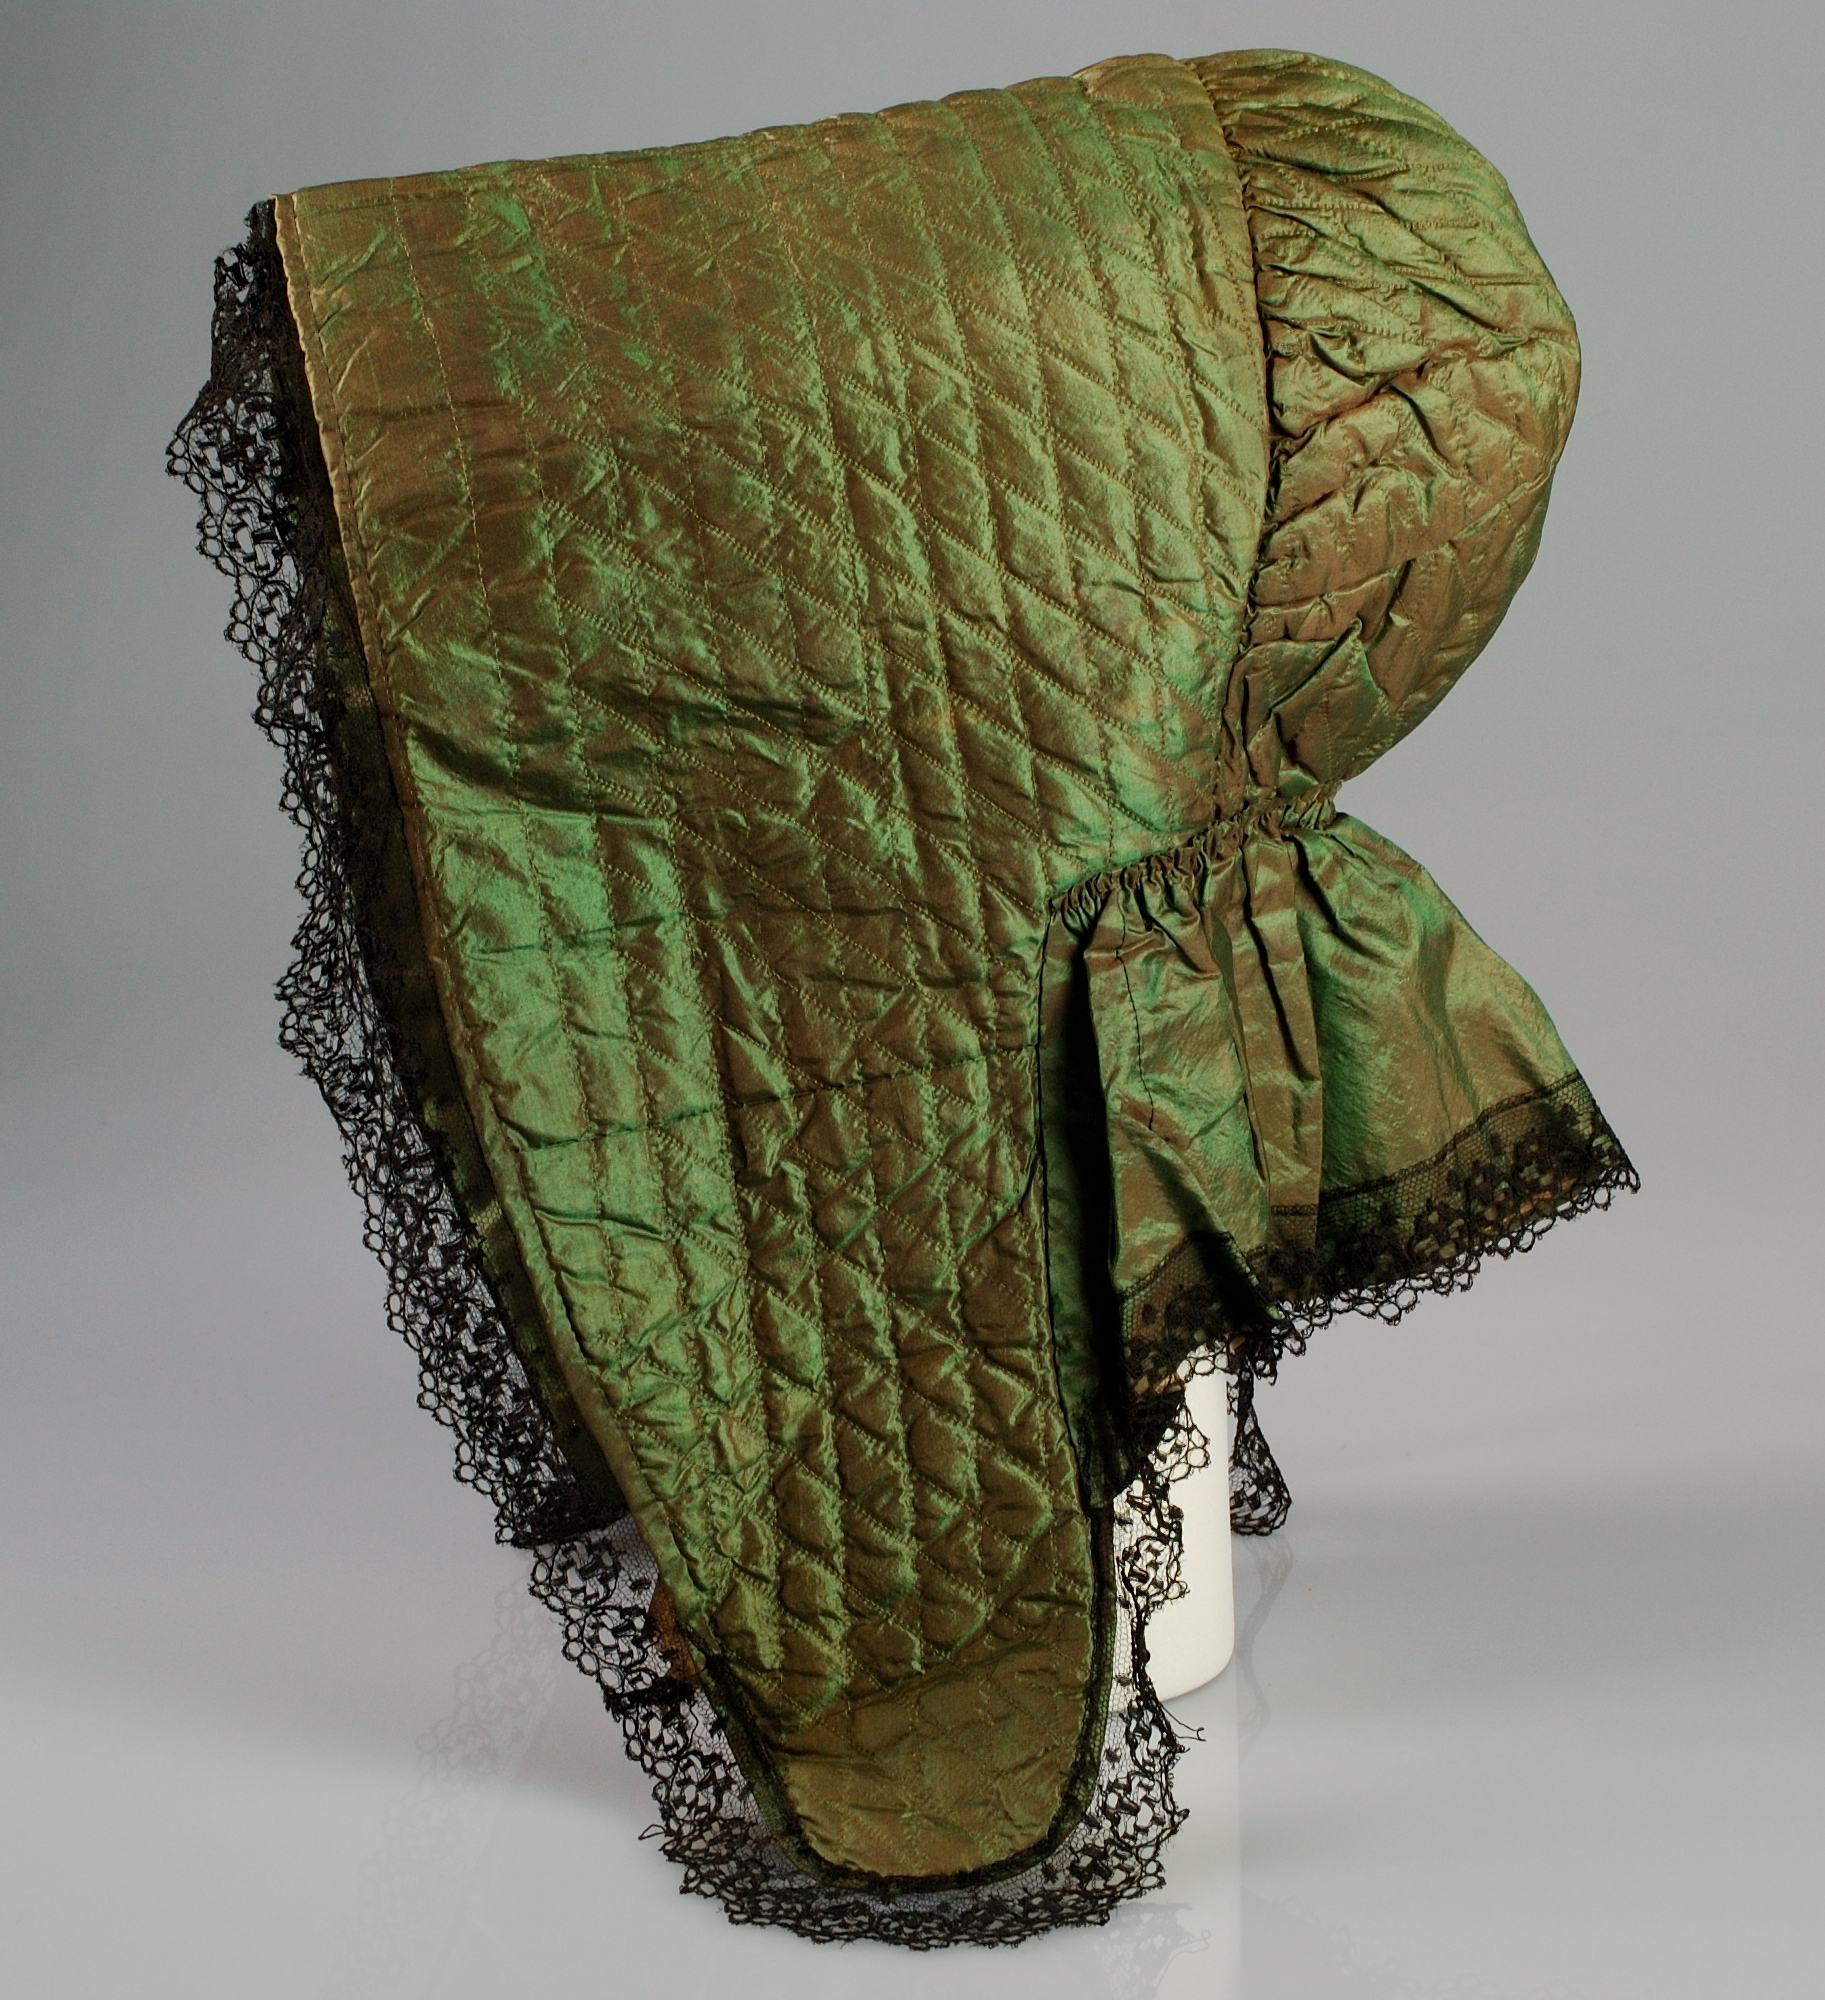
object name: bonnet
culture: american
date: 1850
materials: cotton, silk